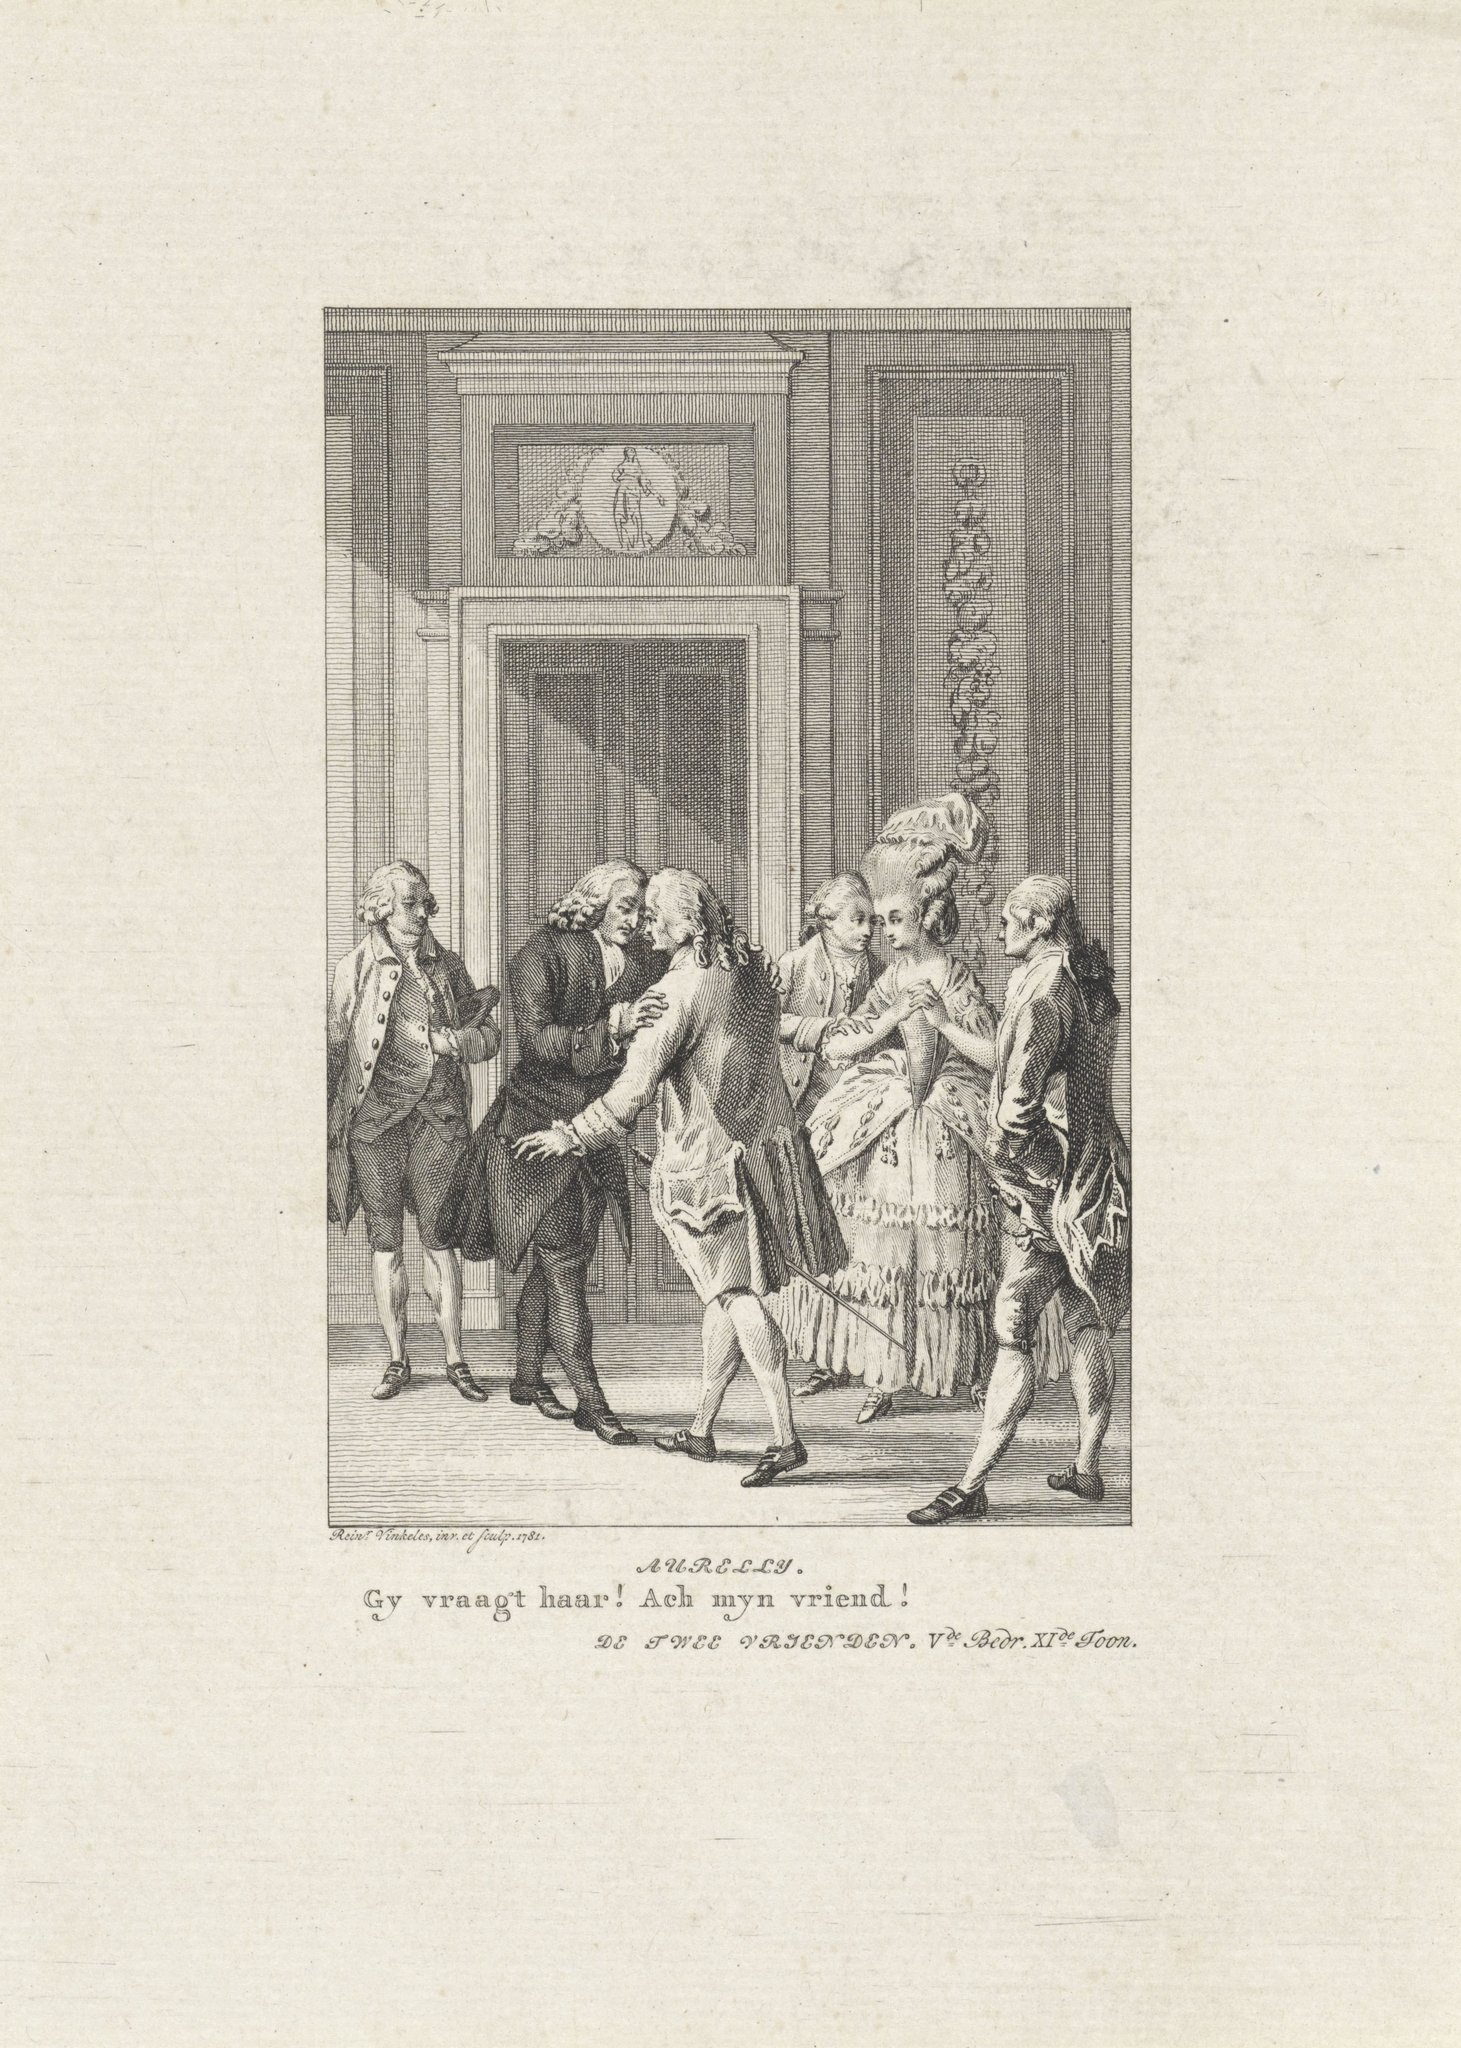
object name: print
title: Twee heren groeten elkaar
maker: reinier vinkeles (i)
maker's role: draughtsman, print maker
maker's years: 1741-1816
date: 1781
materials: paper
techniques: engraving, etching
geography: amsterdam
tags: laying the hand on another person's shoulder, wig, conversation, dialogue; conversation piece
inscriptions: inscription: ‘Aurelly.’, collector's mark: Lugt 240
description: Deze prent is ook gebruikt als illustratie in: Spectatoriaale schouwburg, behelzende eene verzameling der beste zedelyke tooneelstukken, byeen gebragt uit alle (...) taalen van Europa. Deel 10. Amsterdam: Pieter Meĳer en Gerrit Warnars, 1781, p. 217 en p. 364.